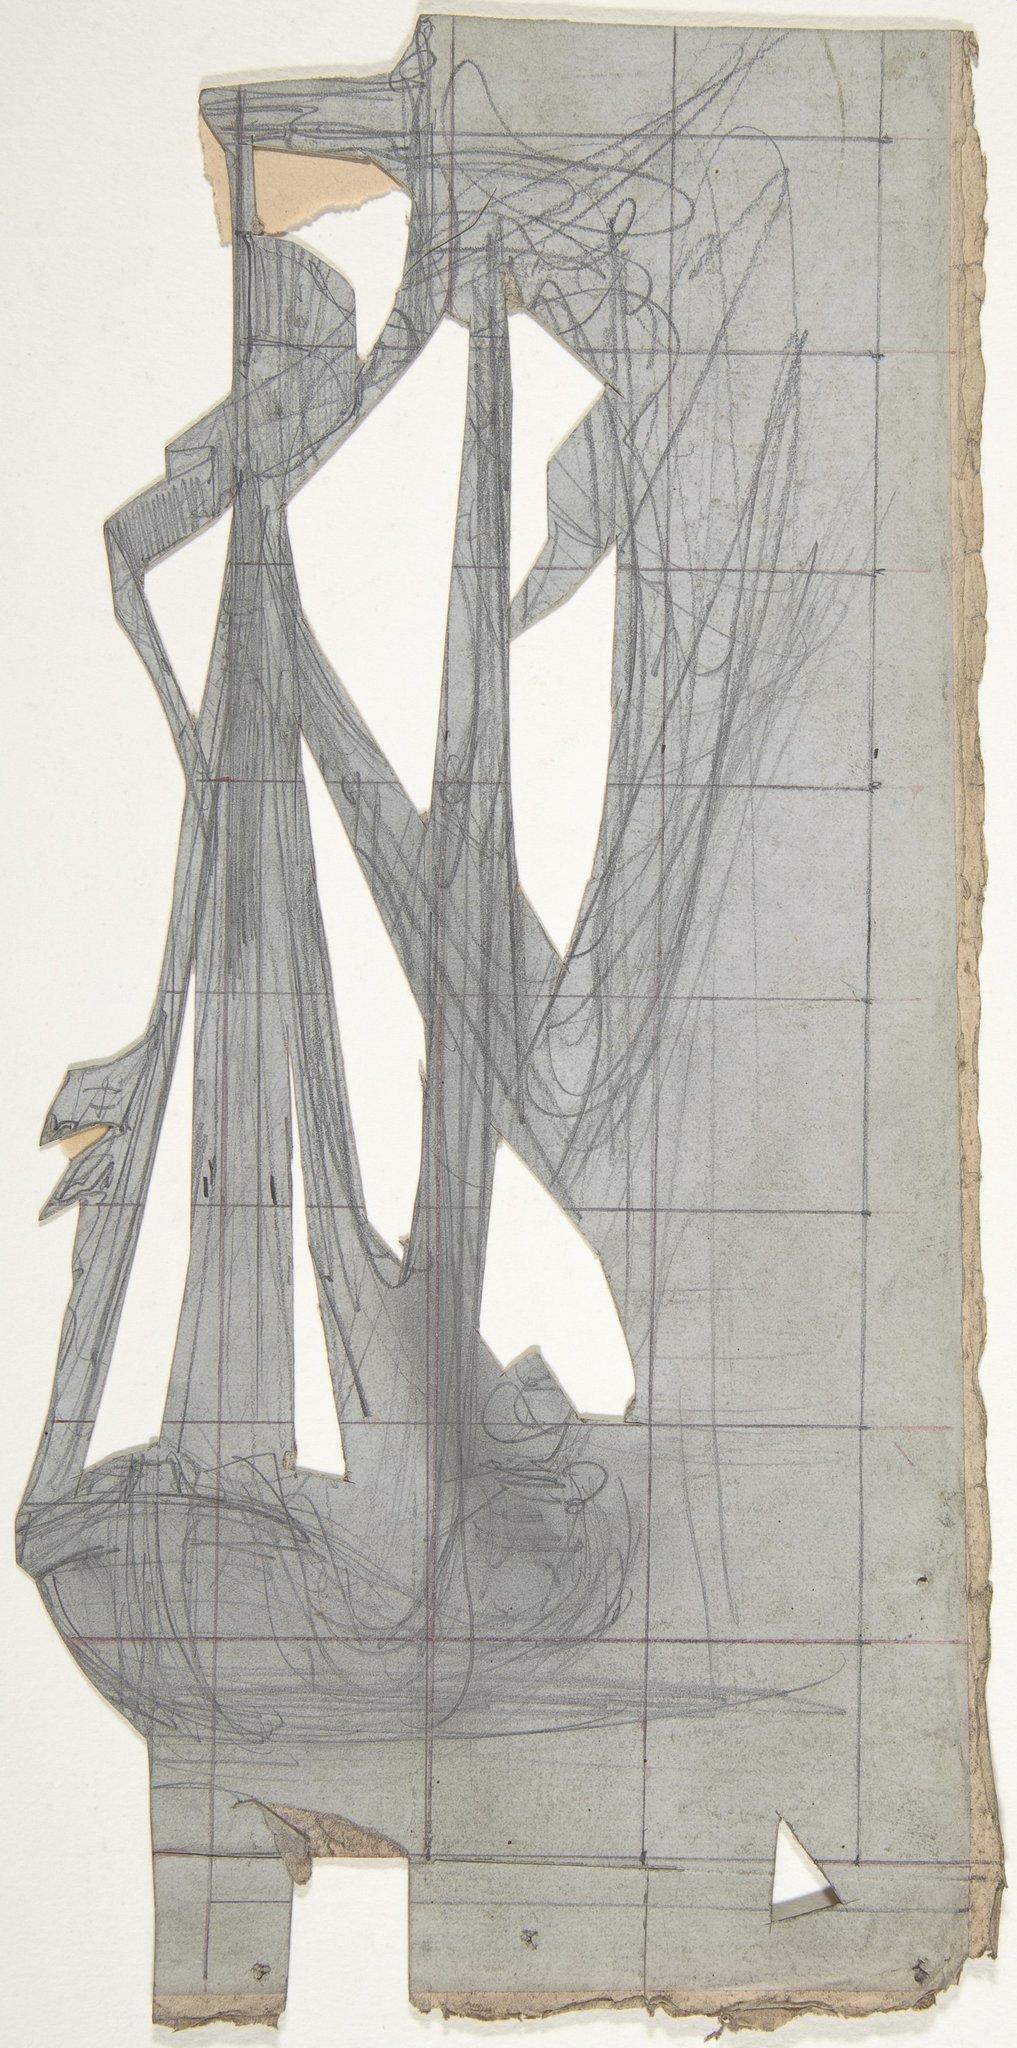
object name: drawing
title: Design for a Stage Set at the Opéra, Paris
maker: eugène cicéri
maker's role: artist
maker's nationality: french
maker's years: 1813-1890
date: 1830-1890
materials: graphite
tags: stage design